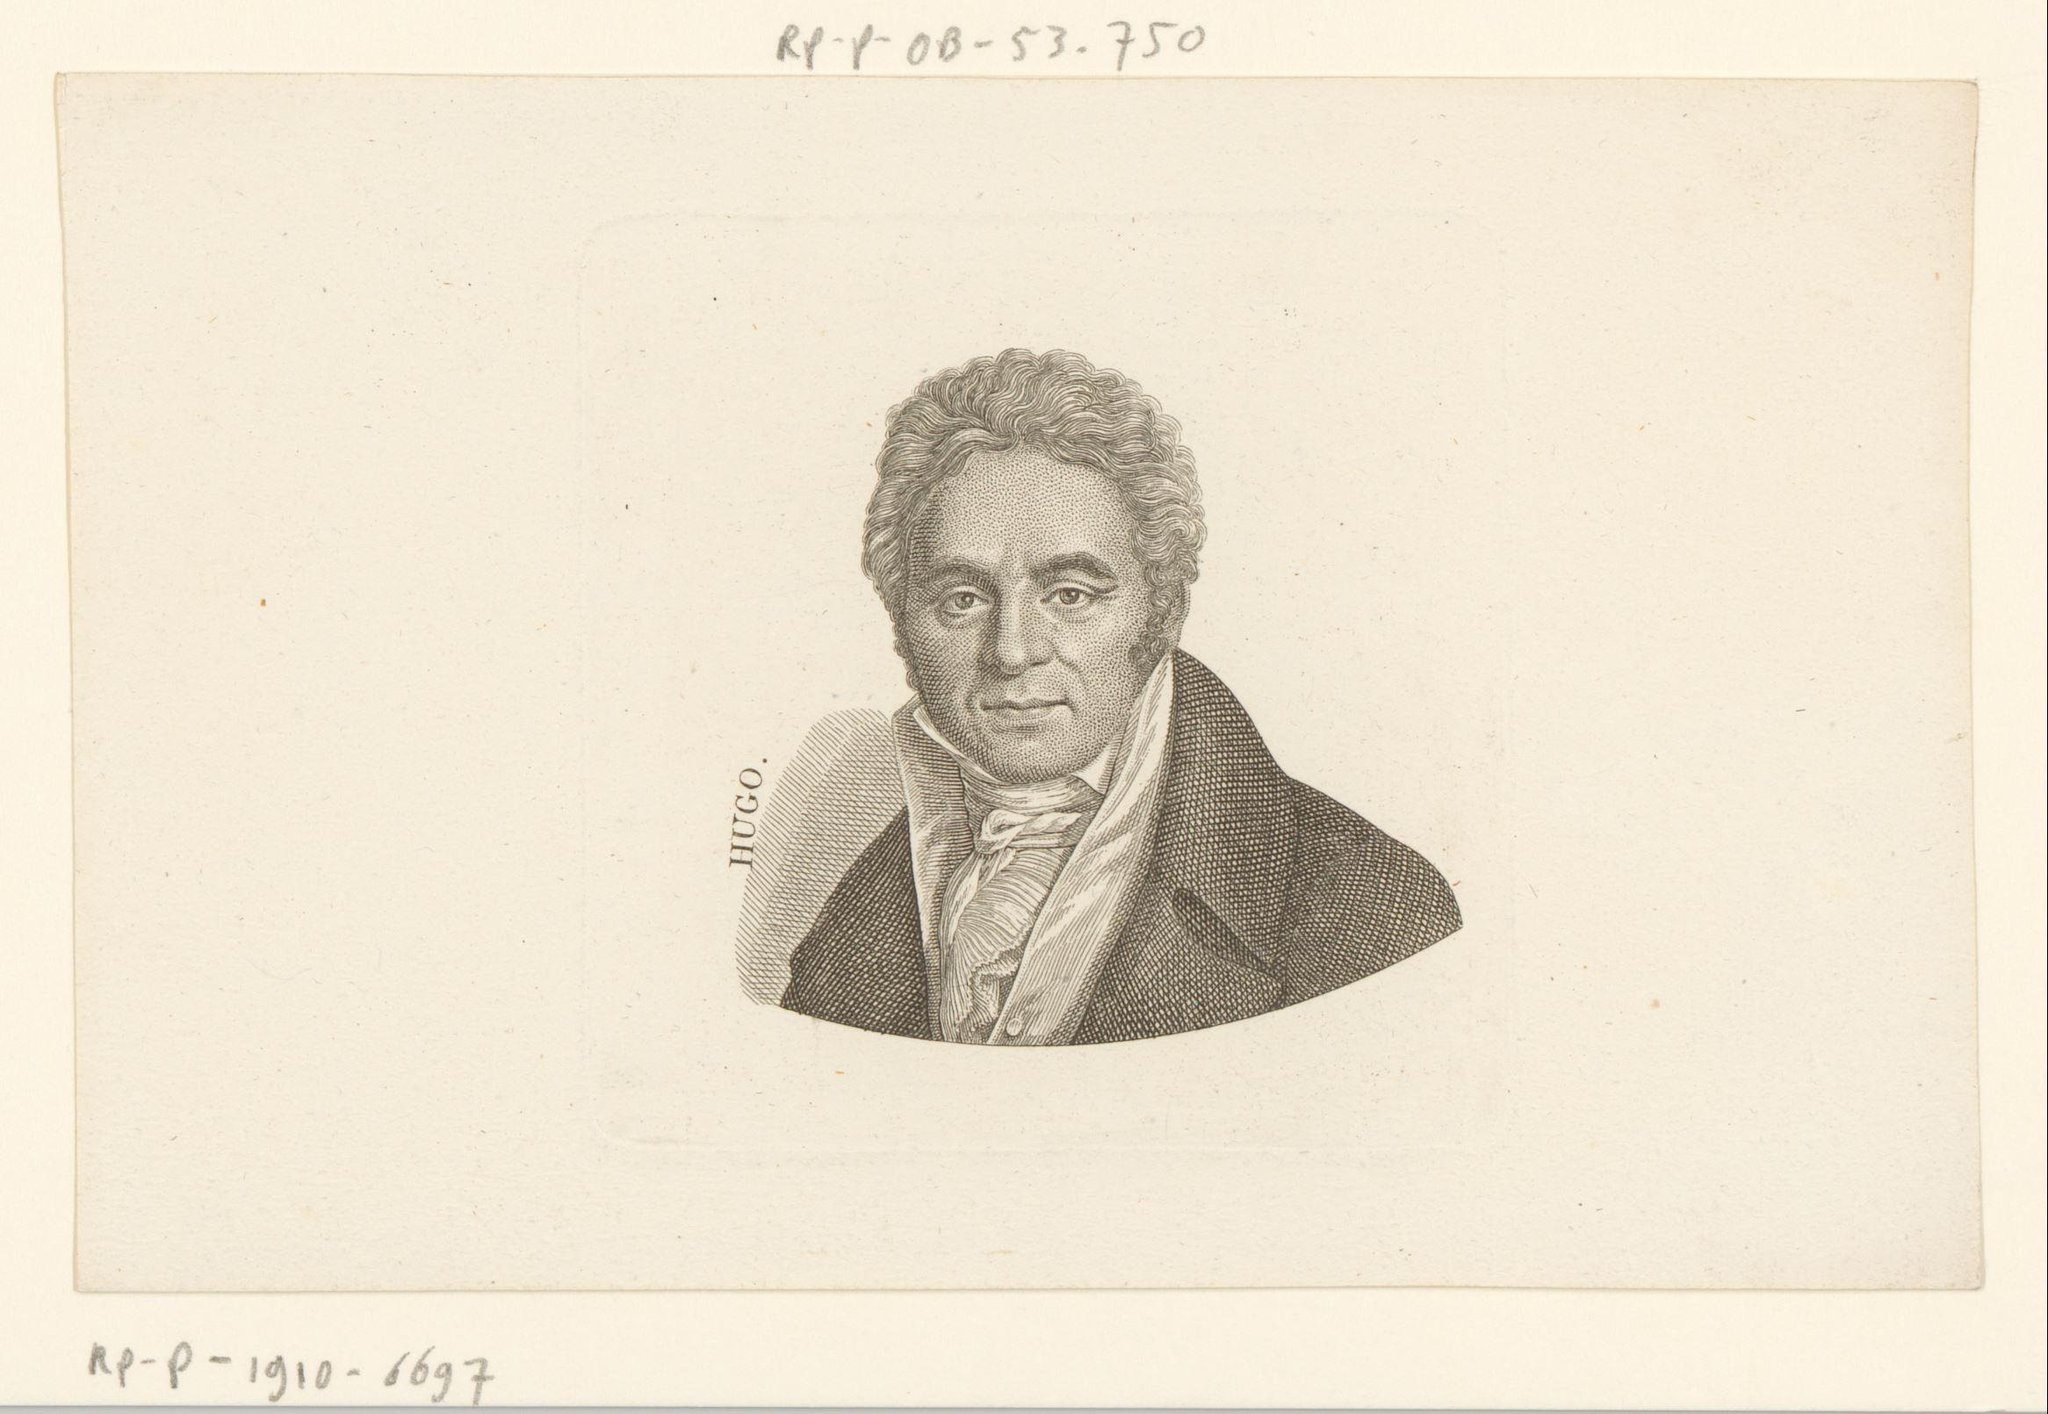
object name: print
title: Portret van Victor Hugo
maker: ernst ludwig riepenhausen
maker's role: print maker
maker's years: 1765-1840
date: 1775-1840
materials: paper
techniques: engraving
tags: paris, victor hugo, historical persons, portrait of a writer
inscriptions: collector's mark: Lugt 2228